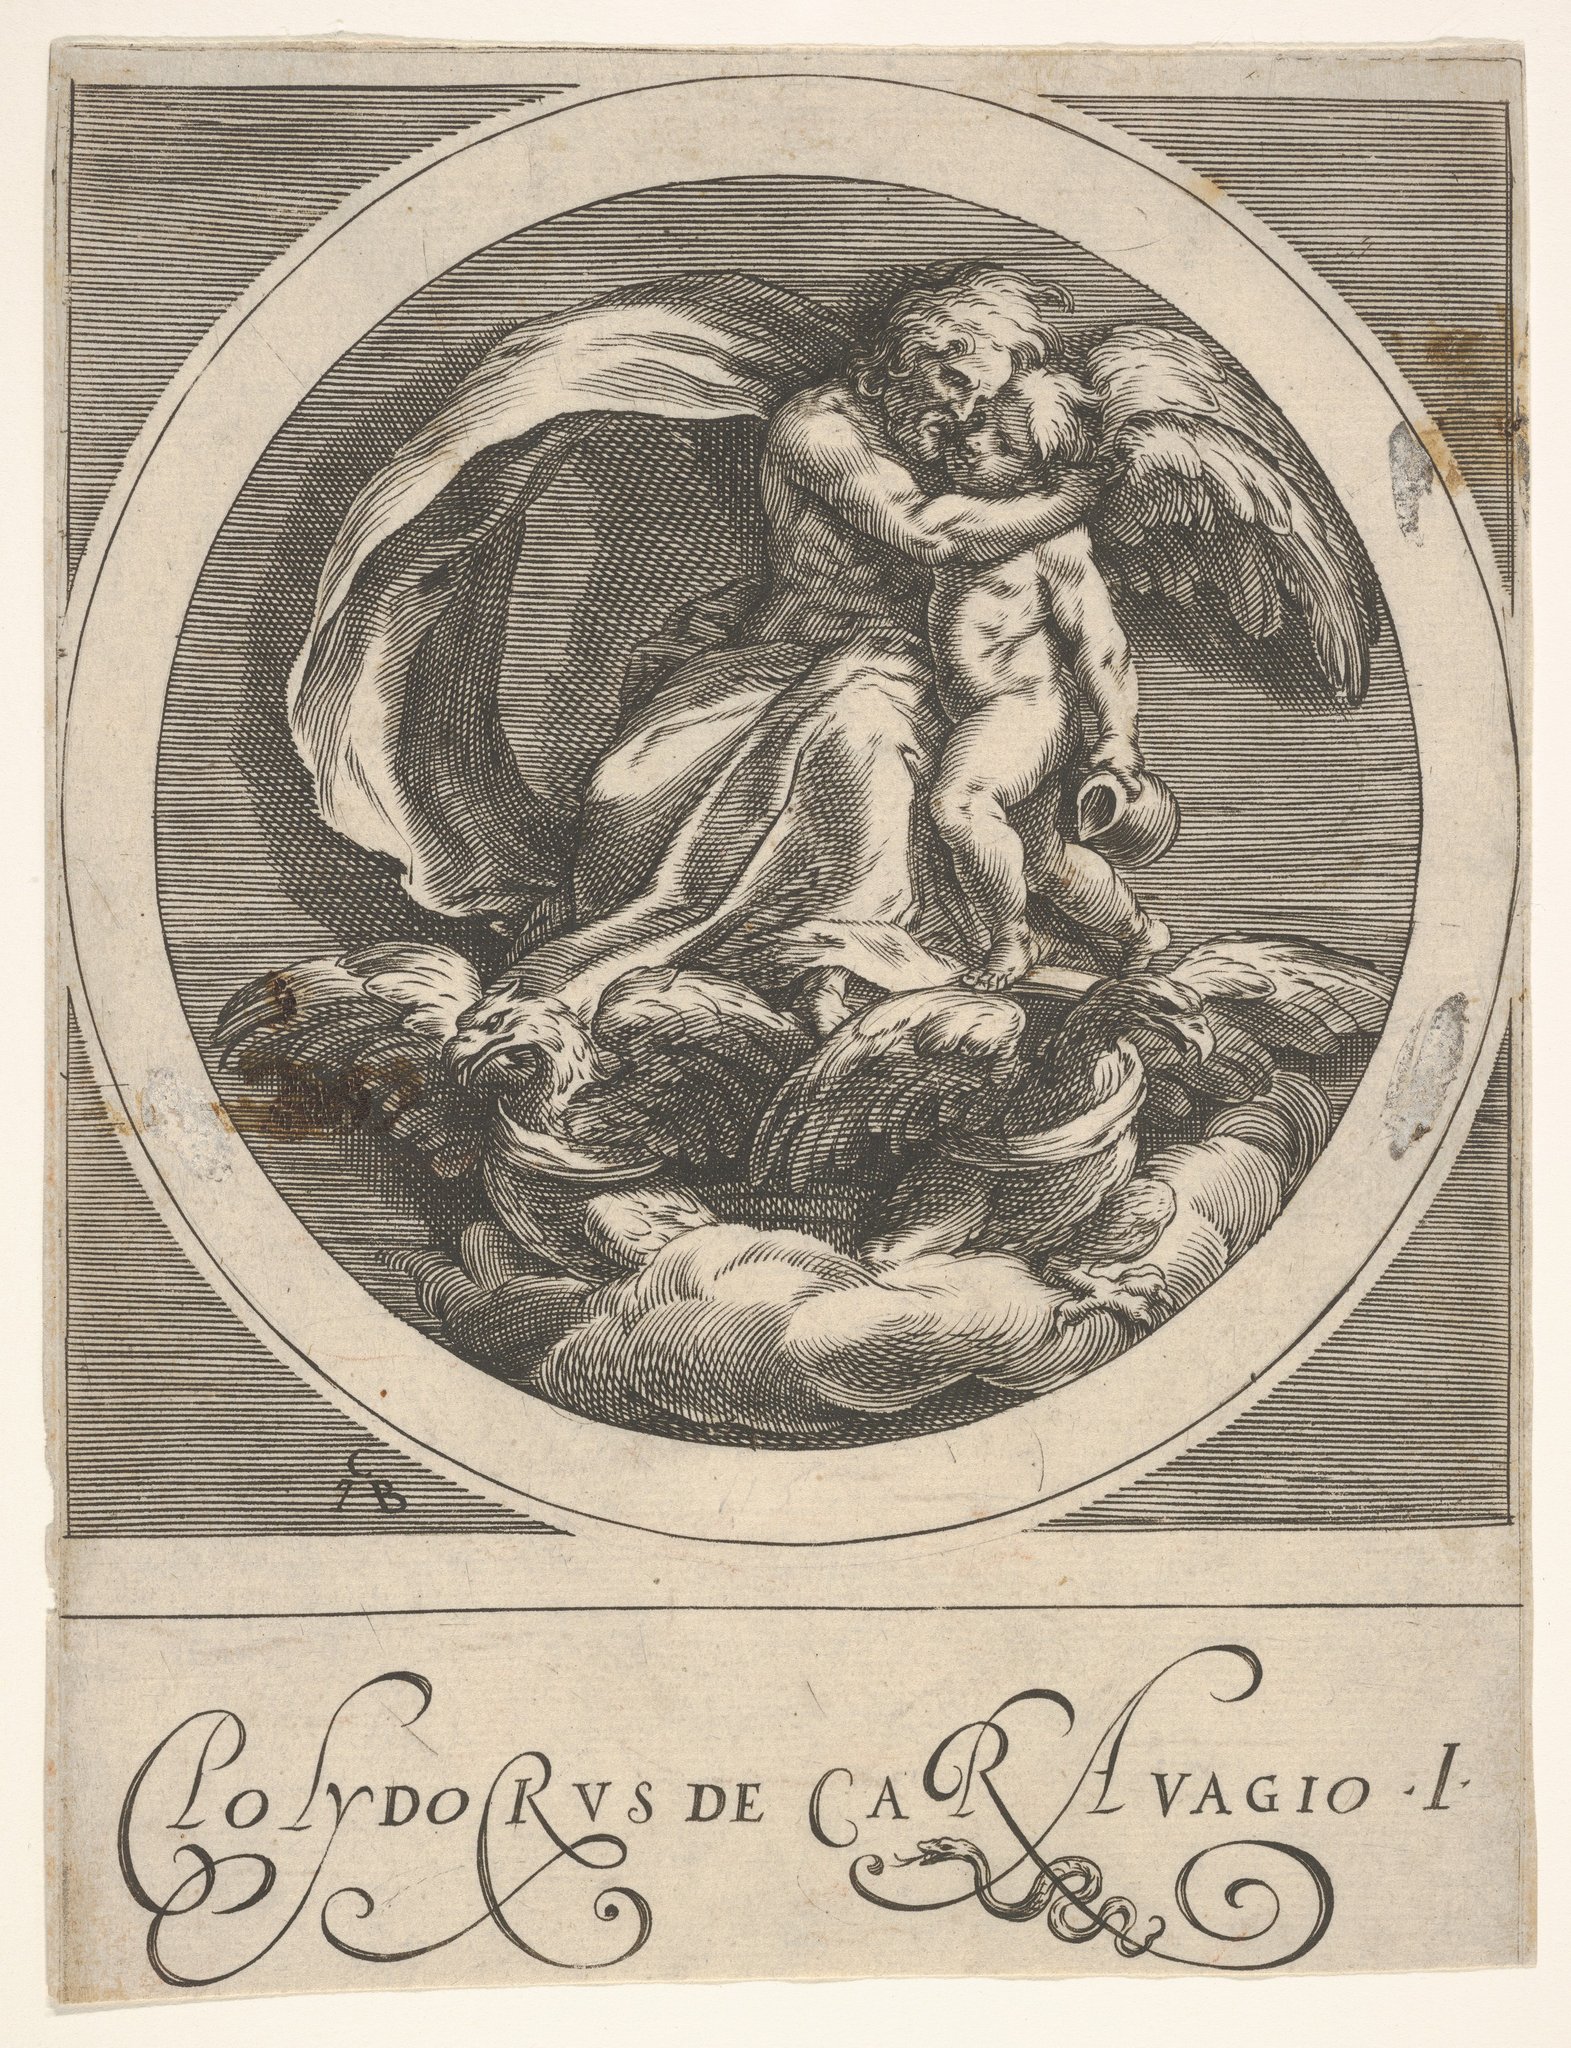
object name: print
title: Jupiter, seated above two eagles and embracing Cupid, a round composition from a series of mythological scenes after Polidoro da Caravaggio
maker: cherubino alberti (zaccaria mattia)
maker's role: artist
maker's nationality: italian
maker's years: 1553-1615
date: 1590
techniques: engraving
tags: eagles,cupid,jupiter